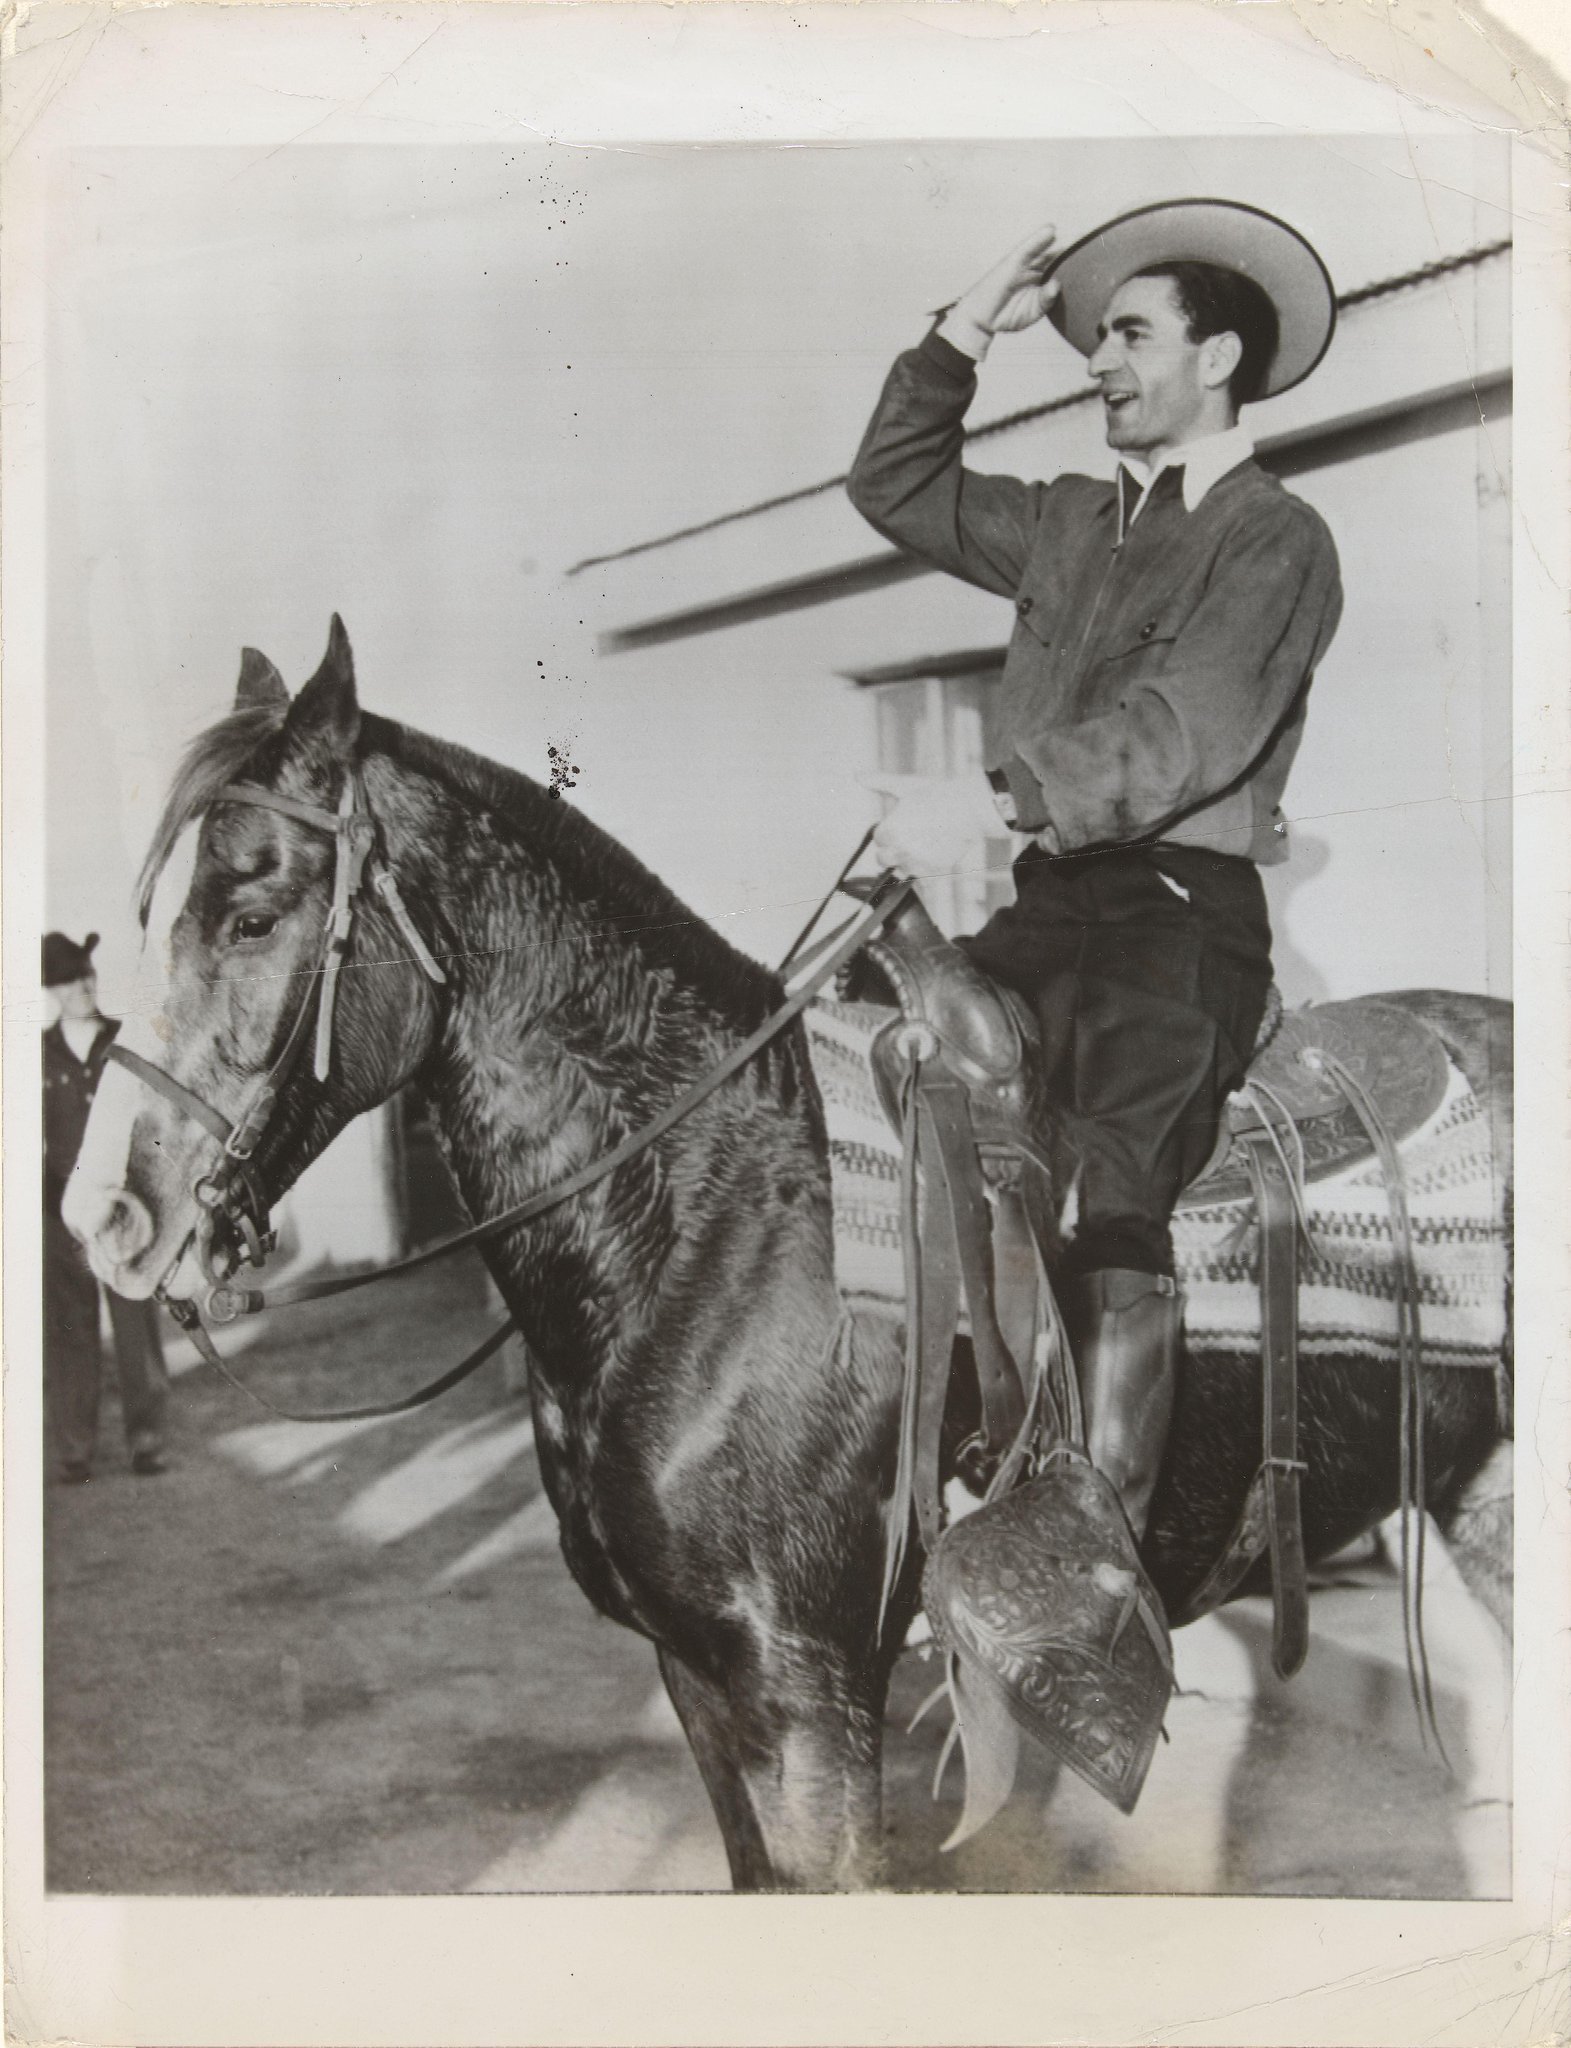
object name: photograph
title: Just an old cowhand from Theheran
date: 1949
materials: photographic support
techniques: gelatin silver print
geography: new york city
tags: mohammed reza pahlavi (sjah van iran), phoenix, arizona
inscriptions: stamp: ‘copyright photo press belgium S.A.’, stamp: ‘International news photos’